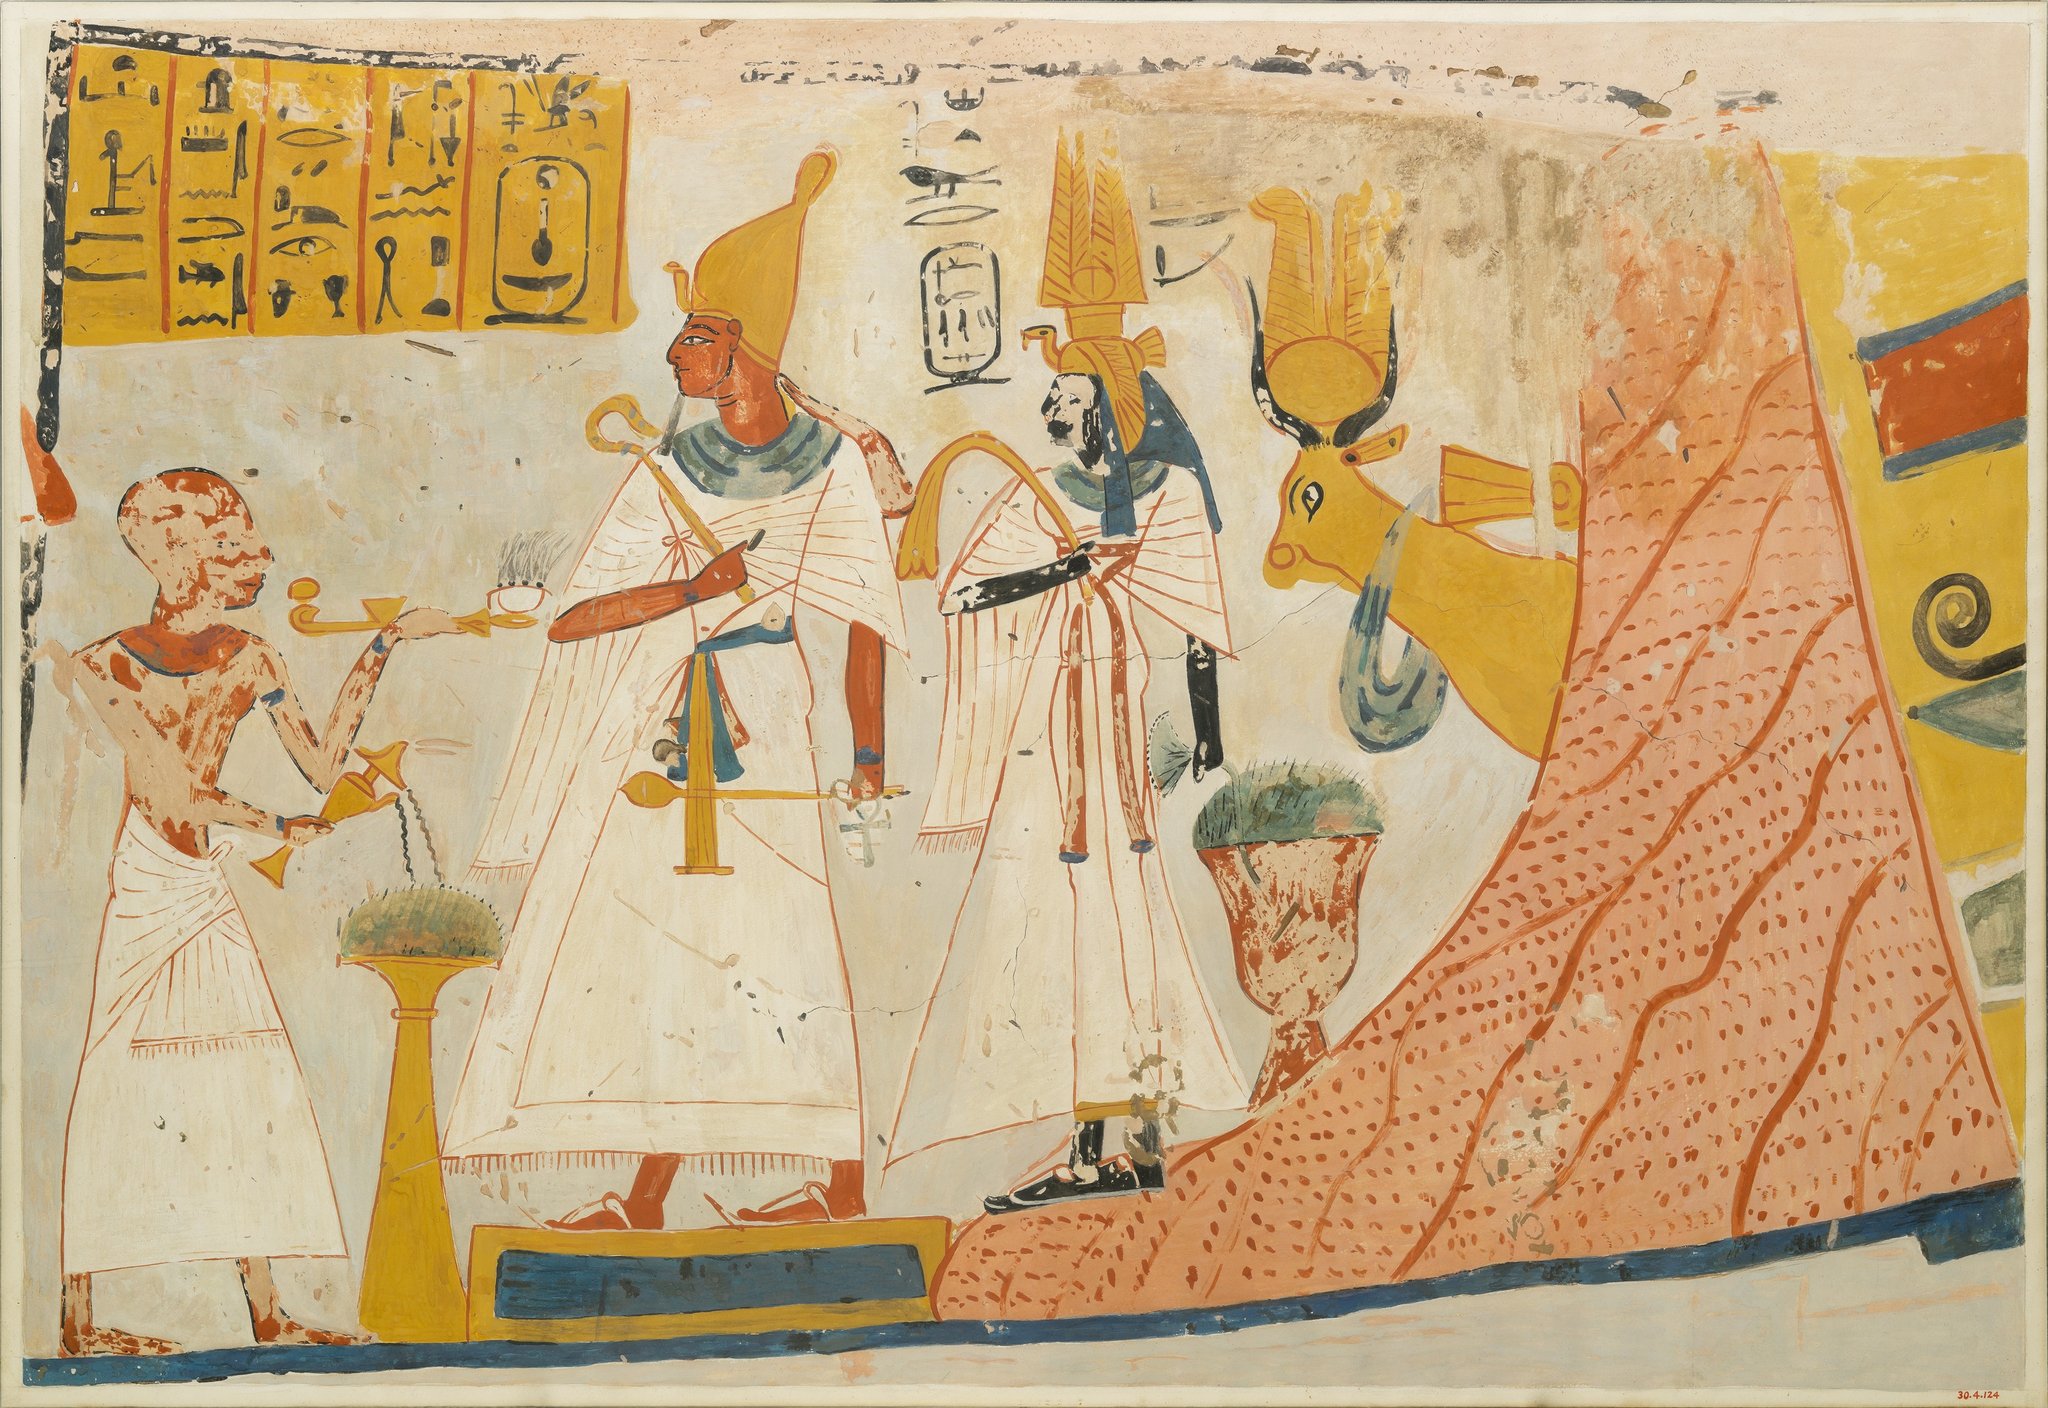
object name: facsimile, ameneminet tt 277, deified mentuhotep, hathor cow, desert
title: Deceased censing and libating to the deified Mentuhotep and Ahmose-Nefertari, with the Hathor cow emerging from the mountain; Tomb of Ameneminet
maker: charles k. wilkinson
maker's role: artist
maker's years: 1897-1986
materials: paper, paint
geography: egypt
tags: nefertiti,men,hieroglyphs,cows